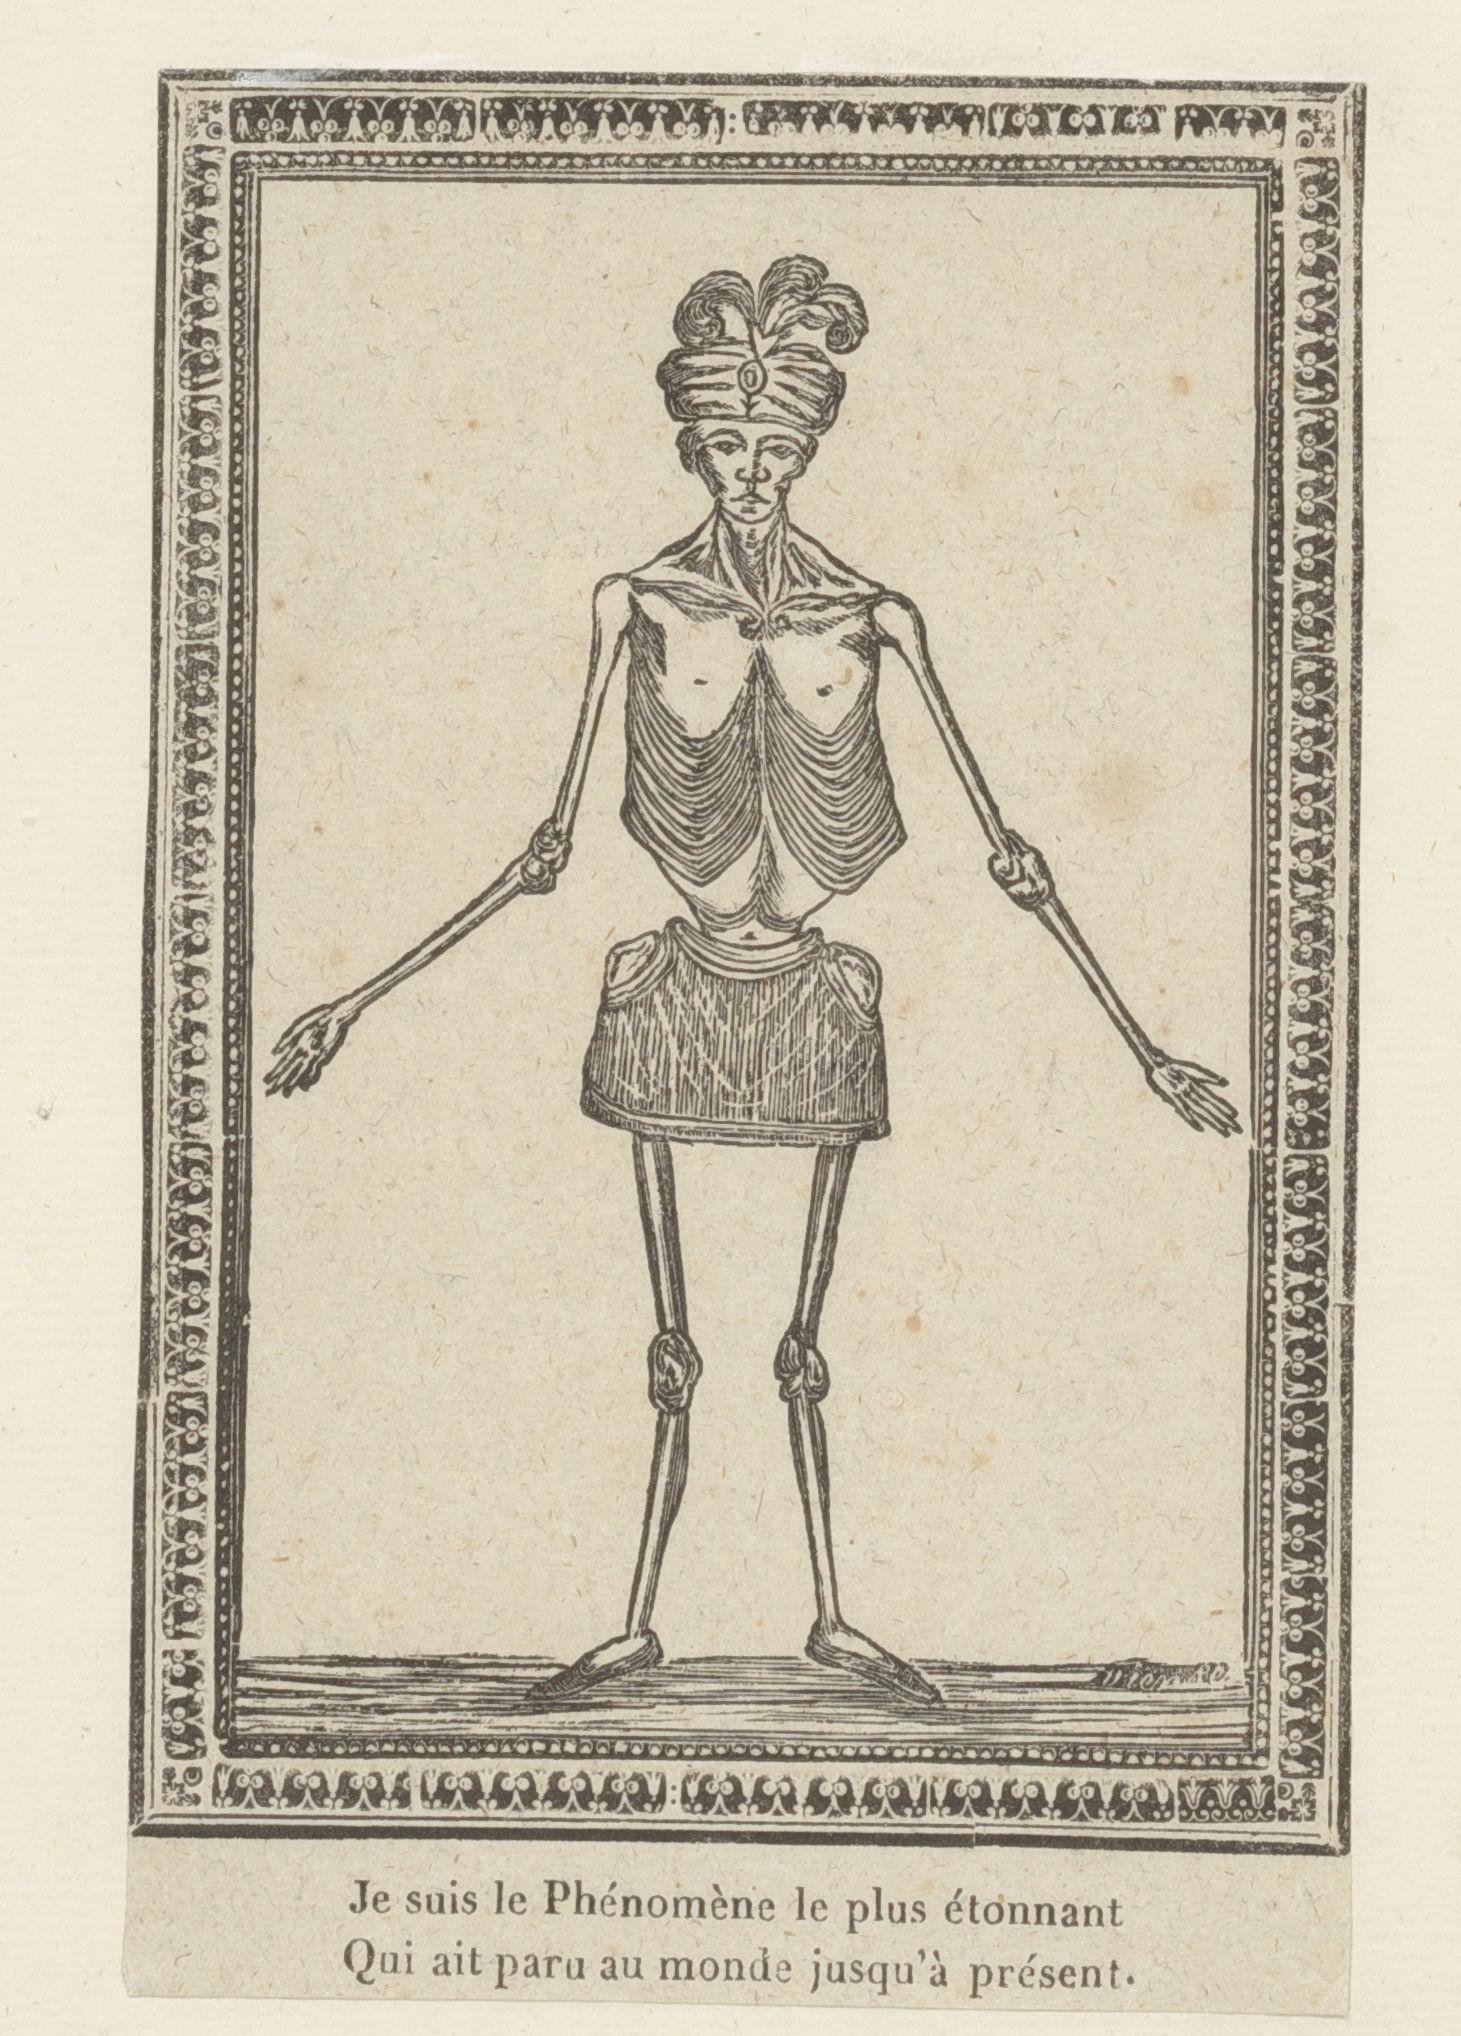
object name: print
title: Man met een zeer dun lichaam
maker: Anonymous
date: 1820-1840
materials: paper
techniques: letterpress printing, engraving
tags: cabinet of curiosities, 'kunst- und wunderkammer', human monstrosities ~ freak show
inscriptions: stamp, collector's mark: Lugt 1641, stamp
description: De man wordt op vergelijkbare prenten aangeduid als het levende geraamte. Onderwerpsrubrieken binnen de Atlas Zeden en Gewoonten: Zeden en Gewoonten in Engeren Zin. Volksleven. Volksfeesten. Kermistypen, wondermenschen en dergelijken.